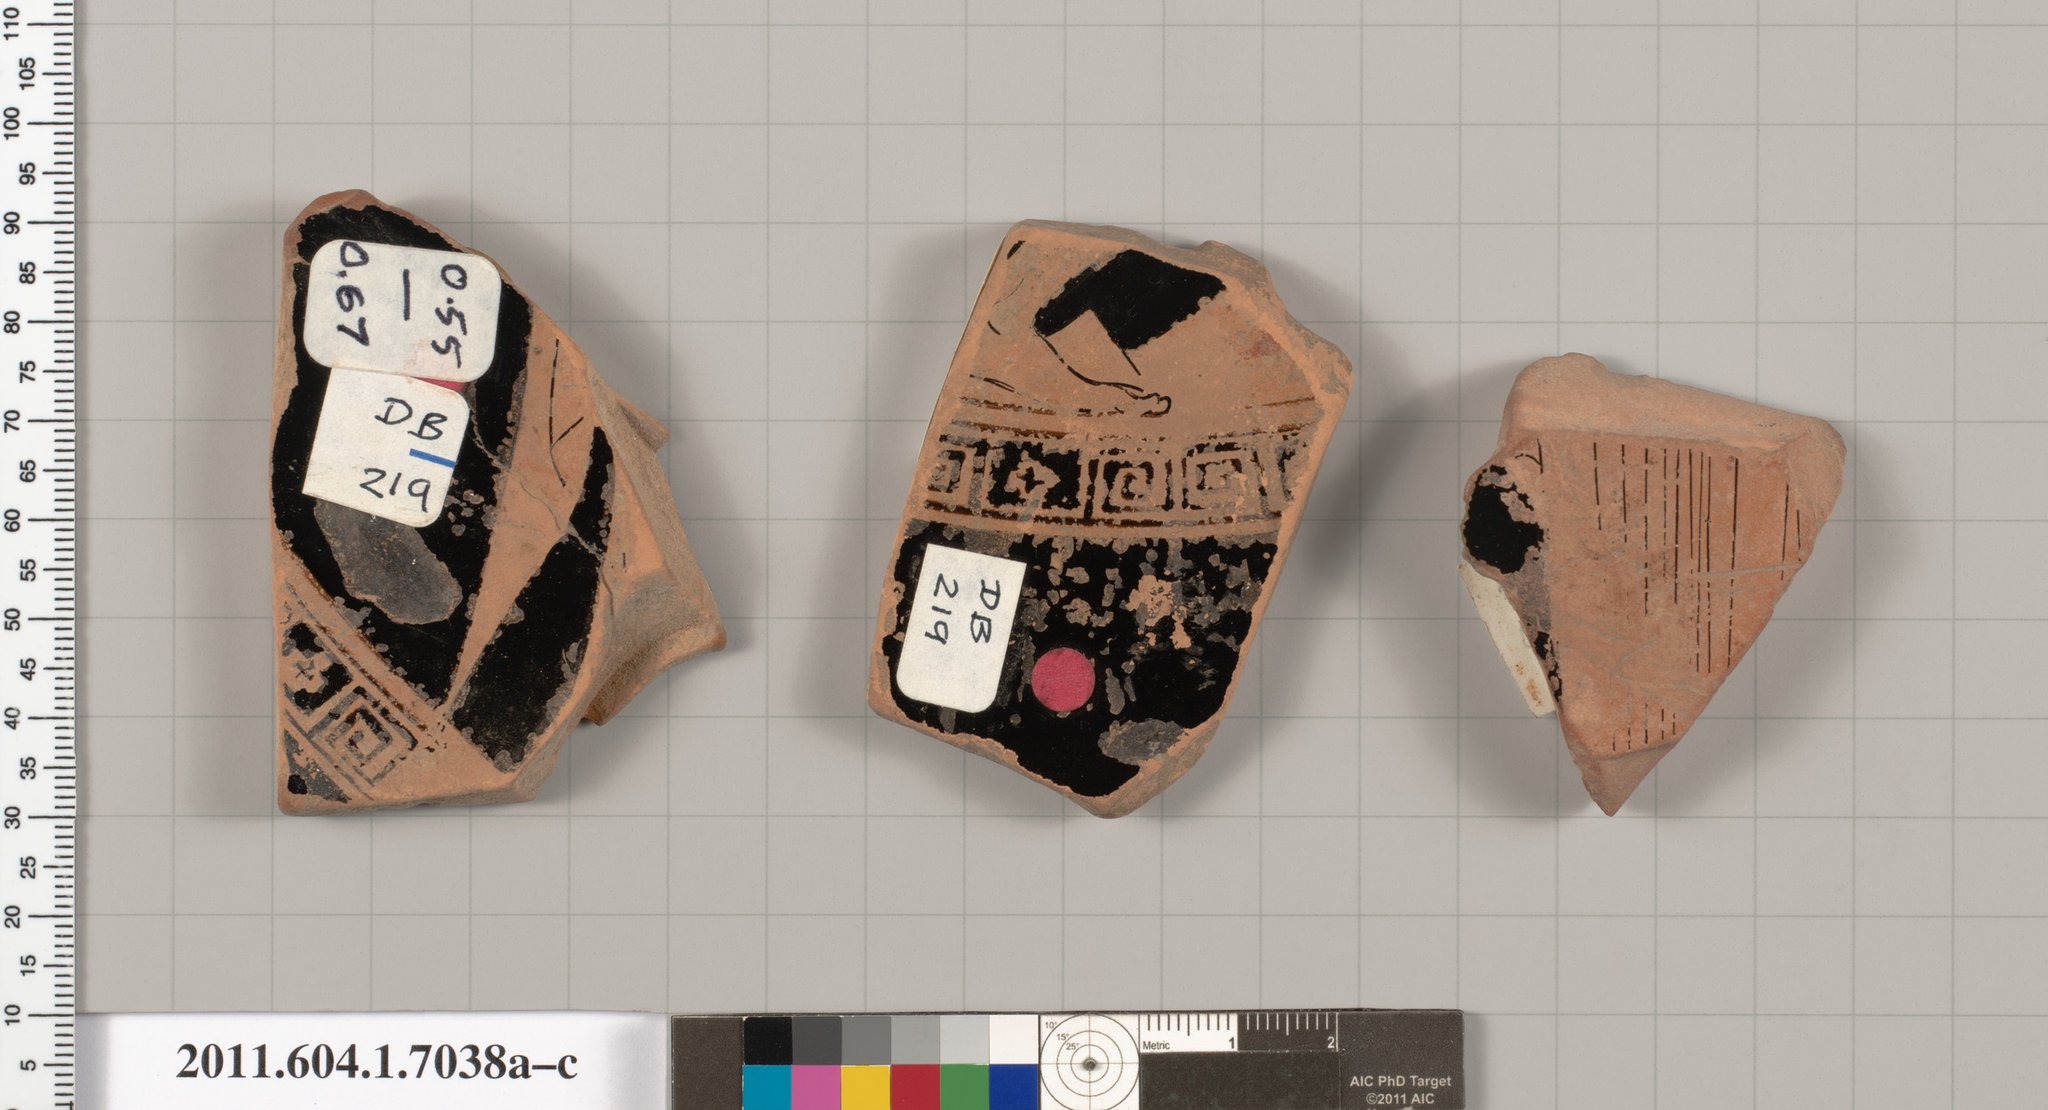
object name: kylix fragment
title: Terracotta fragments of a kylix (drinking cup)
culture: greek, attic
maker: douris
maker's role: artist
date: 500-480 BCE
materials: terracotta